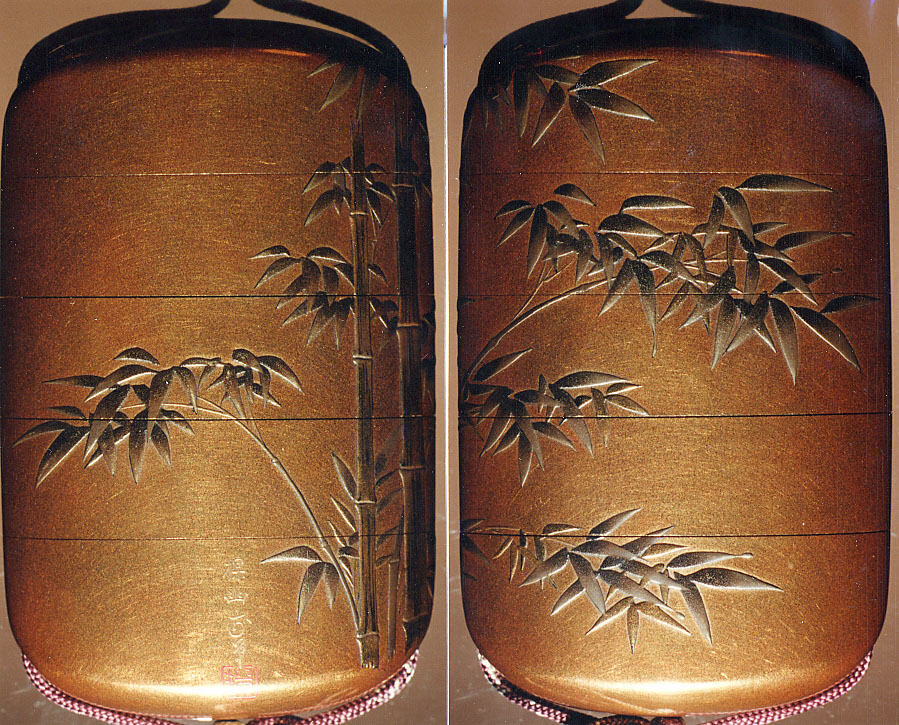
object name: inrō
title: Inrō with Bamboo Grove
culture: japanese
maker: yūtokusai gyokkei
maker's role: artist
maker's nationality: japanese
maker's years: 1800-1850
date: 1834-1866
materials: bamboo, gold, lacquer, metal, silver, wood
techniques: hiramakie, inlay, lacquer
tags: bamboo